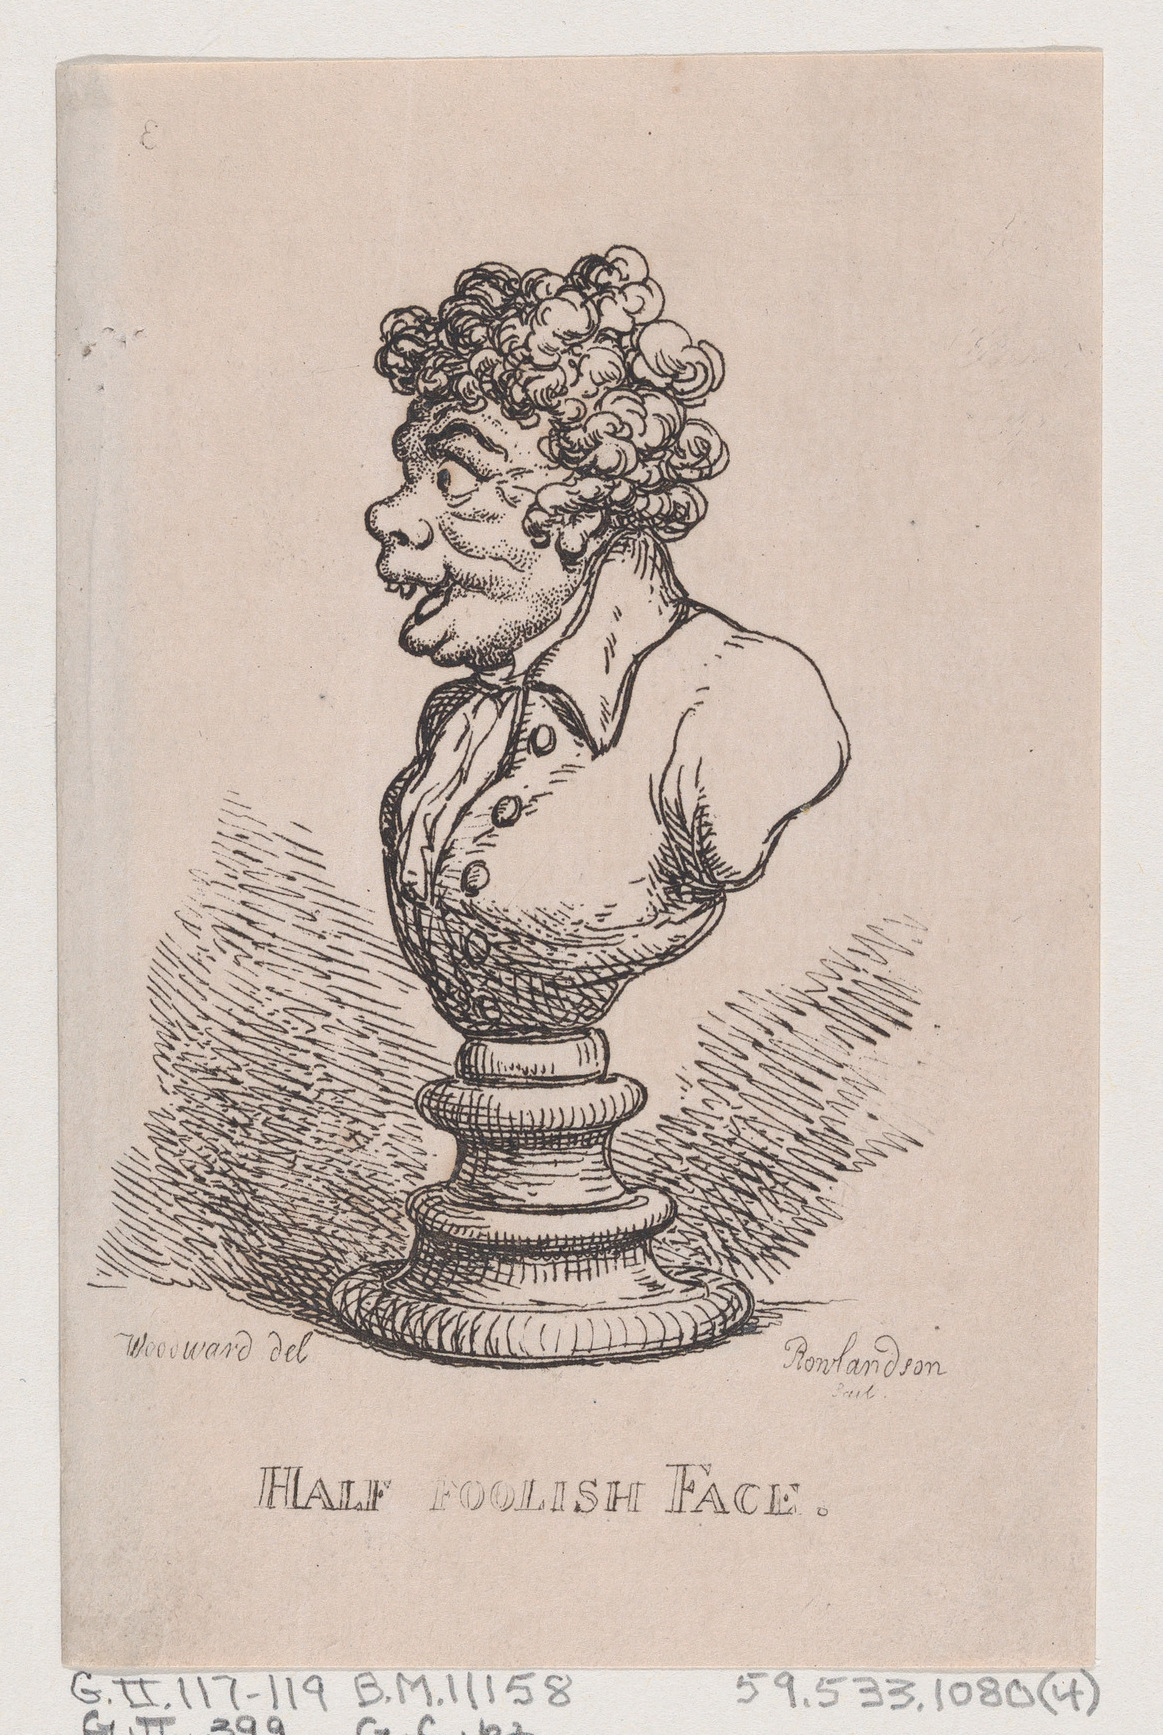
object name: print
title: Half Foolish Face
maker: thomas rowlandson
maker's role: artist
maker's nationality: british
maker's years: 1757-1827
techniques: etching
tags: faces,men